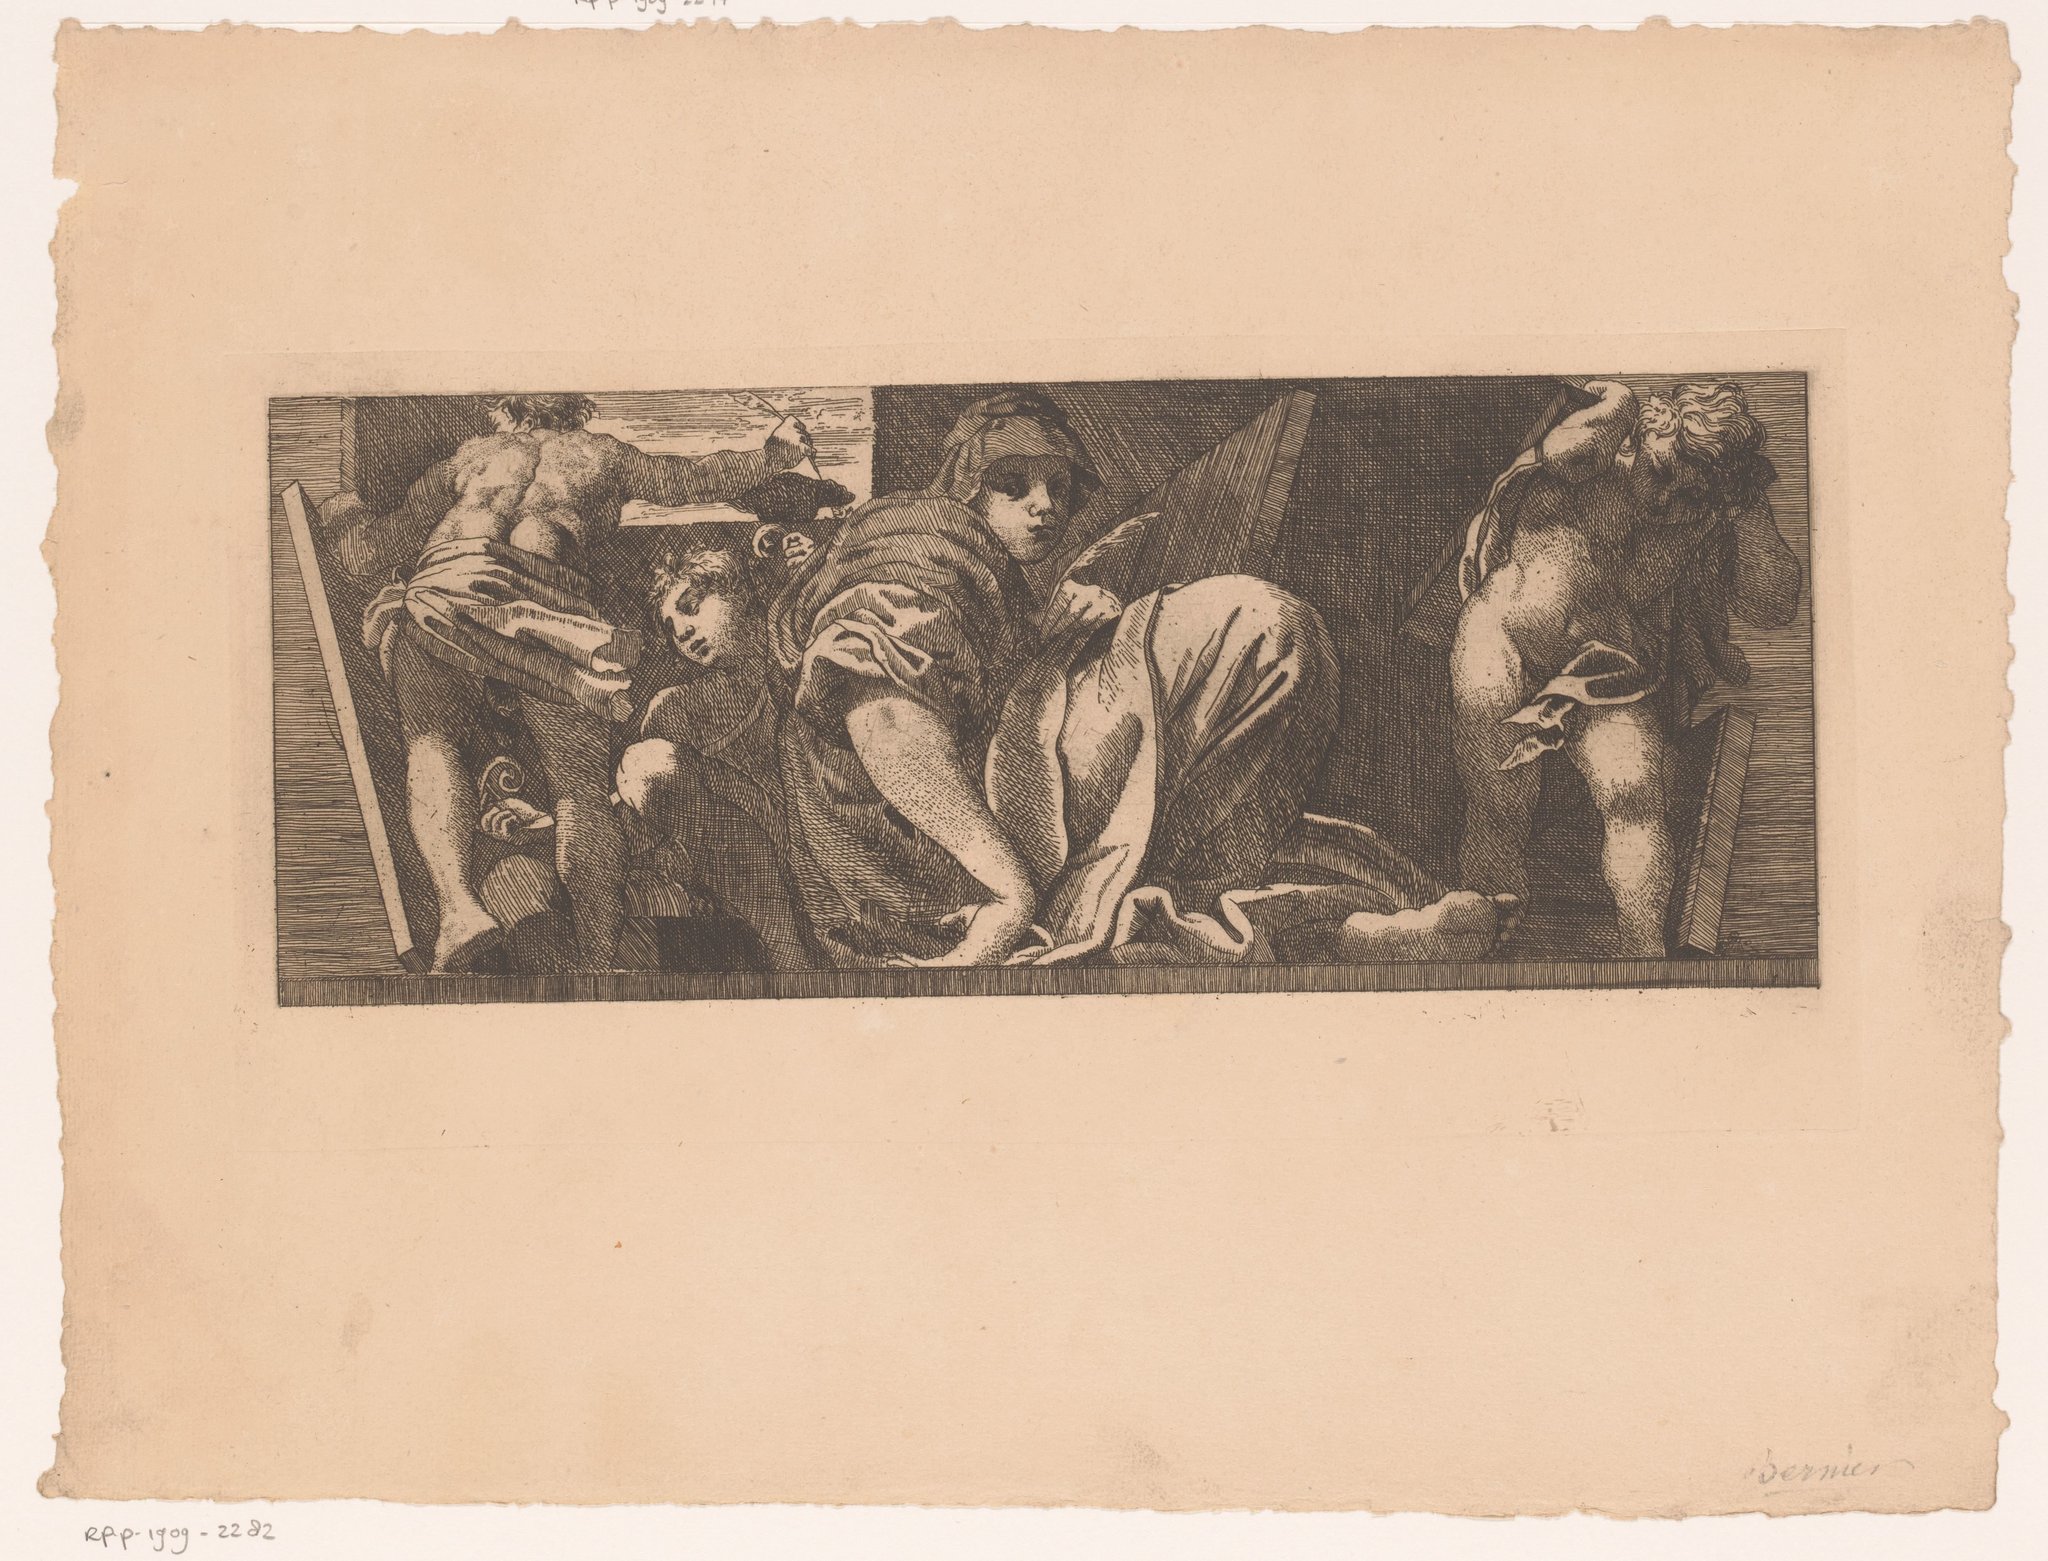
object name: print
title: Zittende jonge vrouw en putti met graveergerei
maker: charles théodore bernier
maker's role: print maker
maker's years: 1871-1950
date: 1881-1909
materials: paper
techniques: etching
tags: cupids: 'amores', 'amoretti', 'putti', craftsman ~ applied arts, engraving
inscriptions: collector's mark: Lugt 2228